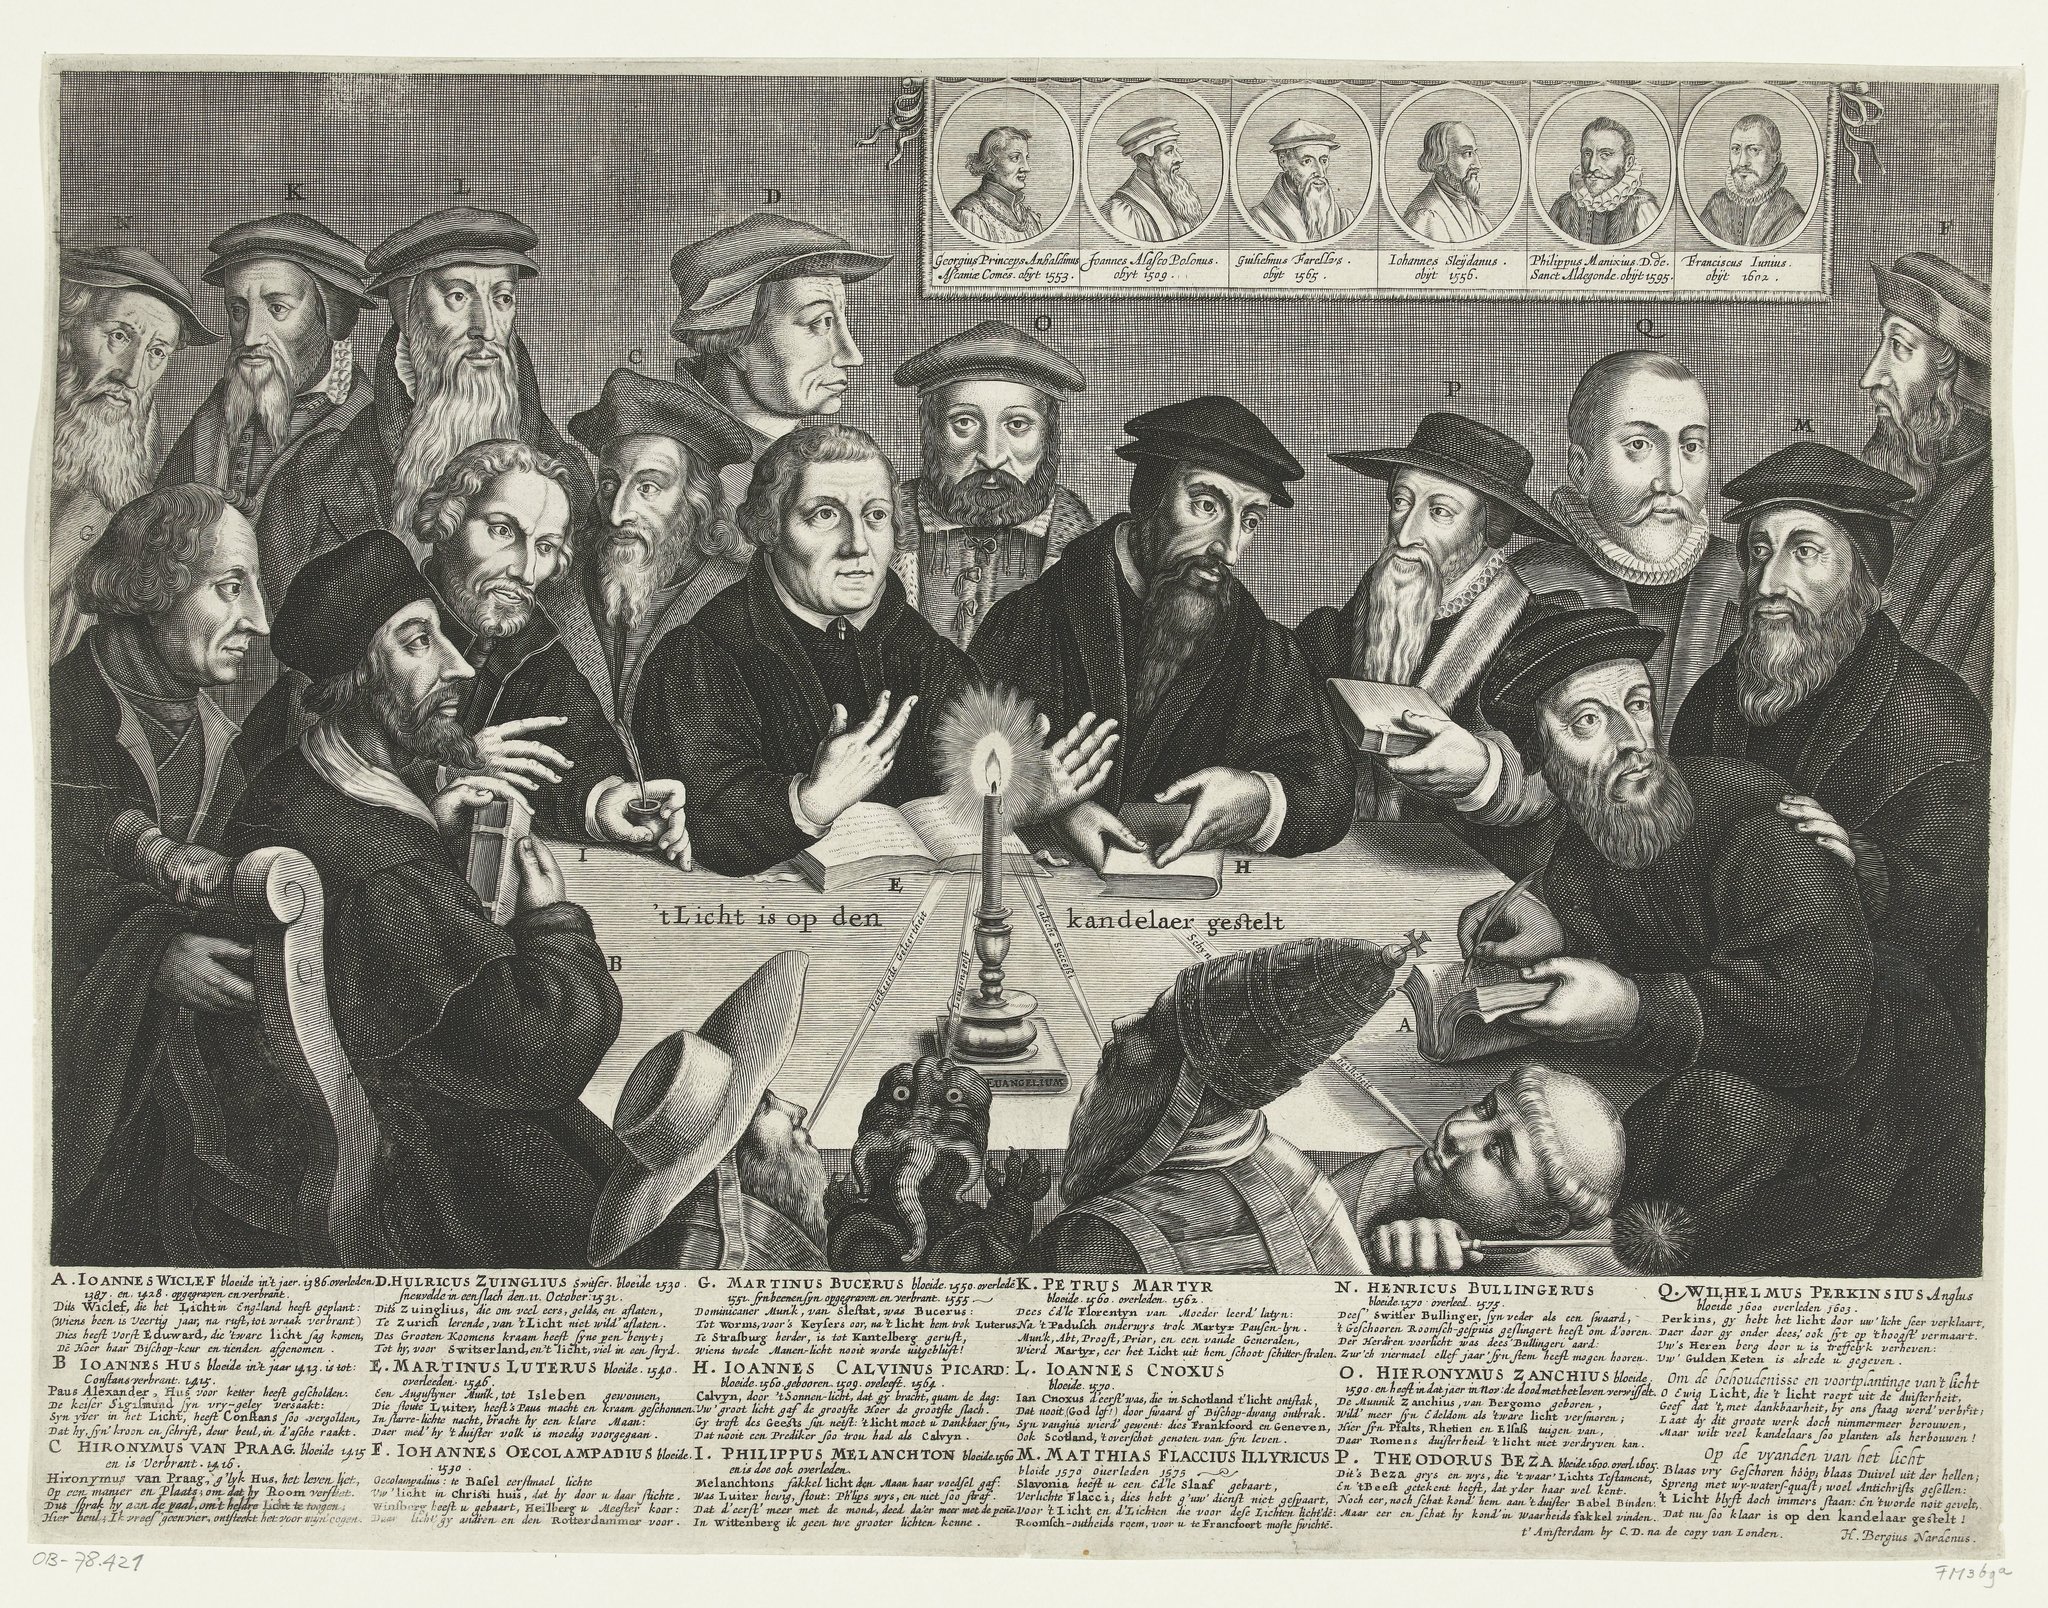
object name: cartoon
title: 't Licht is op den kandelaer gestelt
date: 1640-1699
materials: paper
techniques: engraving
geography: amsterdam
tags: theodorus beza, prague, priest, martin luther, reformation (roman catholic church vs. protestantism)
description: Anti-roomse spotprent met een groep van reformatoren gezeten om een tafel waarop een brandende kaars staat. De kandelaar staat op een boek aangeduid als de Evangelie. De duivel, de paus, een kardinaal en een monnik proberen tevergeefs de kaars uit te blazen. De figuren zijn met letters aangeduid die in het onderschrift, zes kolommen Nederlands, worden verklaard.